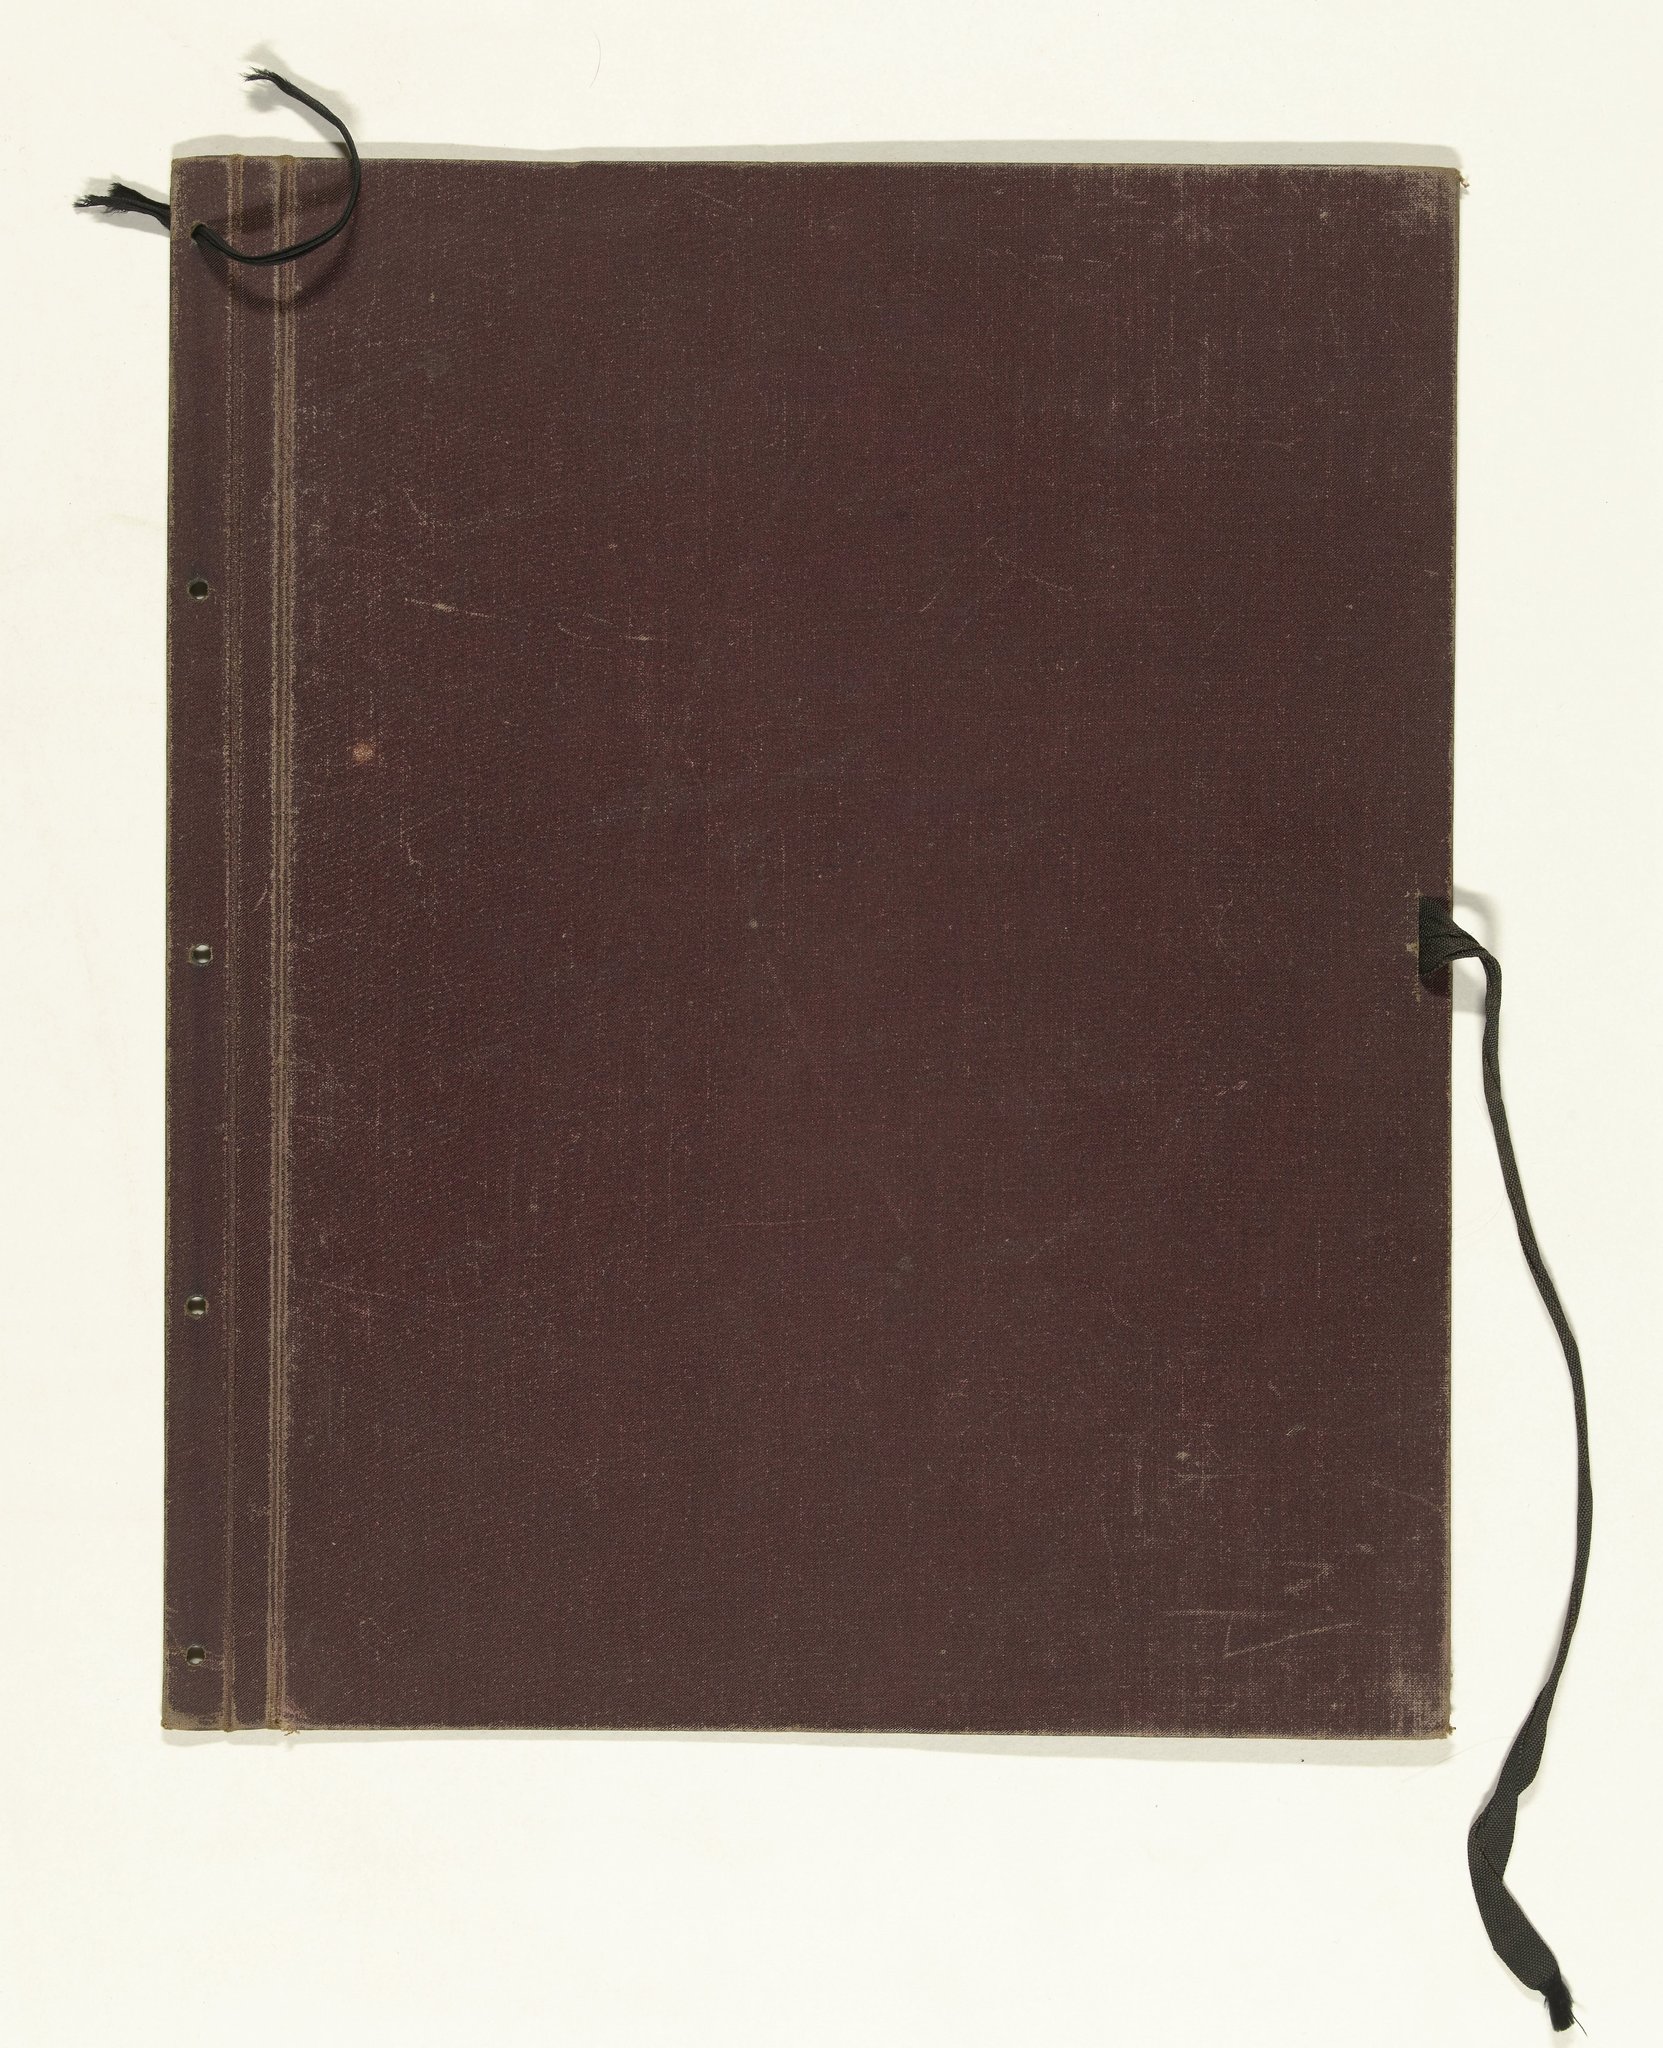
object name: photograph album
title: Studententijd van Henry Pauw van Wieldrecht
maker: henry pauw van wieldrecht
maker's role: fotograaf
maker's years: 1863-1912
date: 1888-1889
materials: paper, photographic support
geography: netherlands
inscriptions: label: ‘ZAEHNSDORF'S / SELF-BINDING / MOUNTS, / [...] / London, W.’, annotation: ‘H. Pauw van Wieldrecht / 1888’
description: Fotoalbum met 46 foto's uit de studententijd van Henry Pauw van Wieldrecht, met opnamen van Hyde Park, portretten, jachtscènes, Kloetinge, Dijnselburg, Hoog Beek en Royen, Zeist, interieurs in huis De Oorsprong (Biltstraat, Utrecht), Utrecht (o.a. ijsterrein), interieur kamer J.W. des Tombe, Plompetoren[gracht?] te Utrecht, interieur kamer Achter St. Pieter 340 te Utrecht, kamer Jenny Pauw van Wieldrecht (Mauritskade, Den Haag).